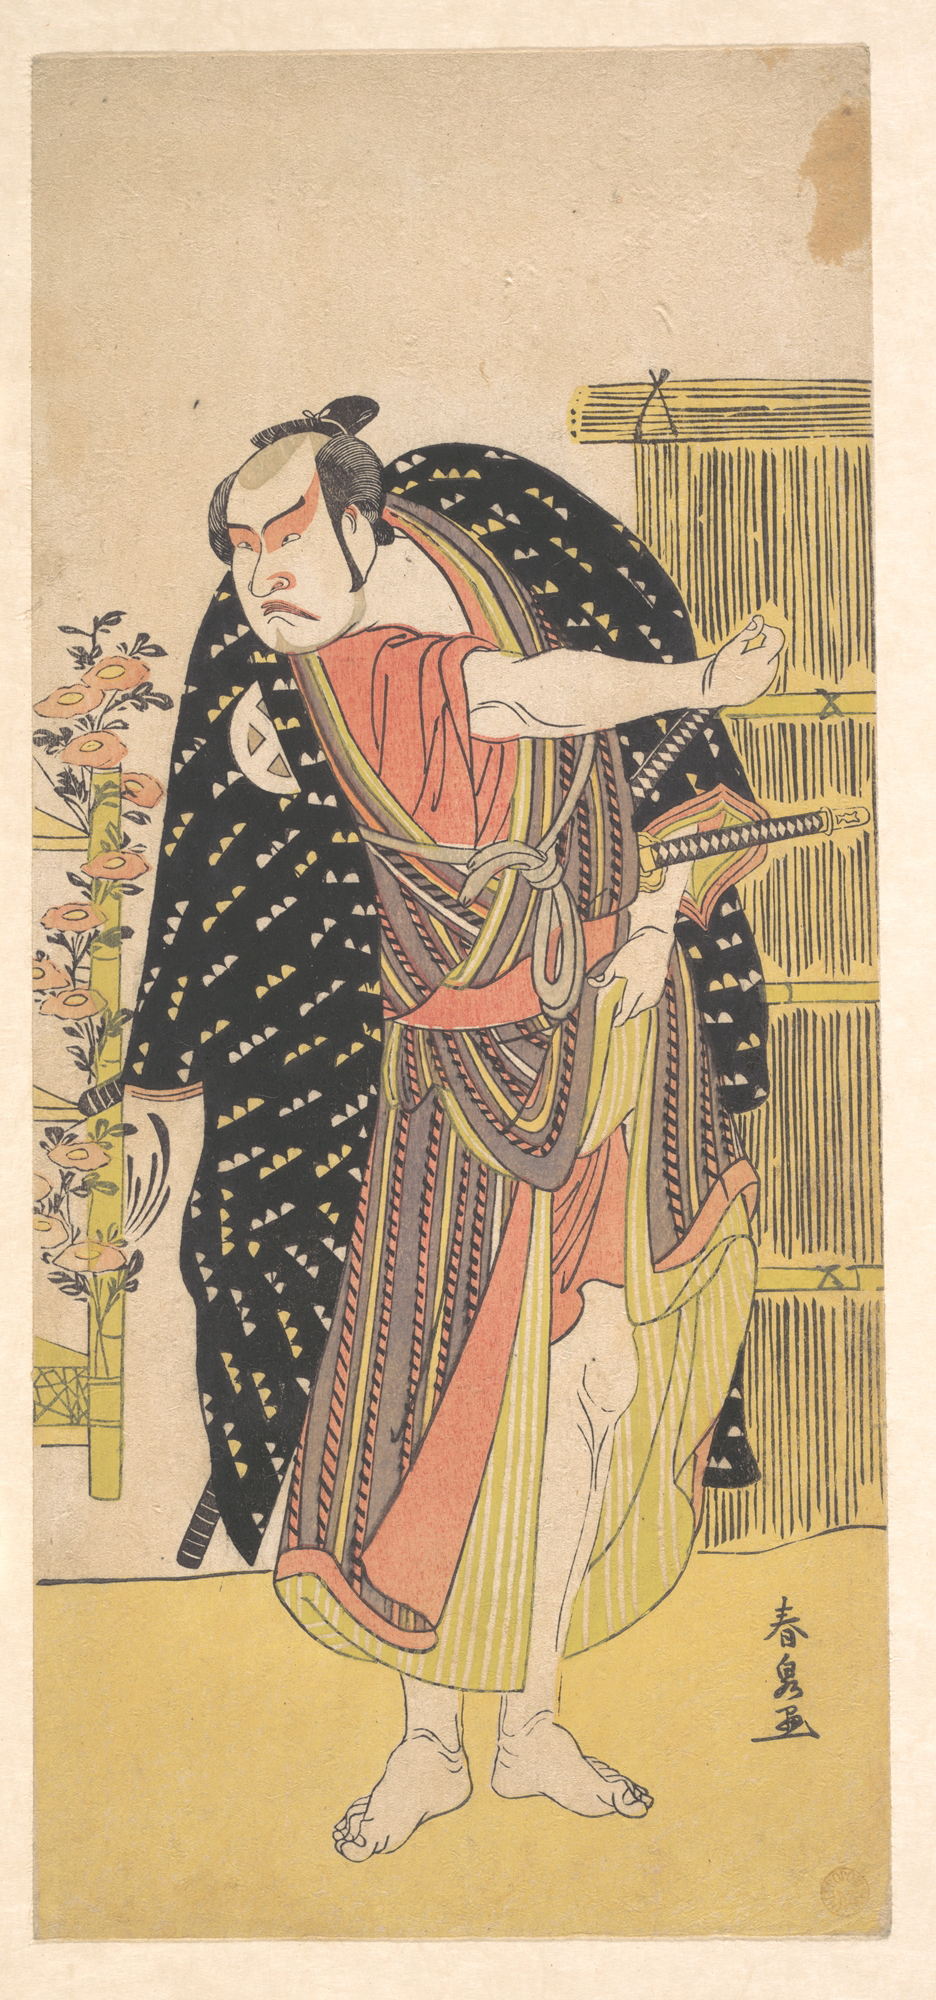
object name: woodblock print nishiki e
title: Kabuki Actor Ōtani Hiroji III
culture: japanese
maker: katsukawa shunsen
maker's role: artist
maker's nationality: japanese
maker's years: 1762-1830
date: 1780-1789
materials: ink, paper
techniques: nishiki e, woodblock print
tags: samurai,men,actors